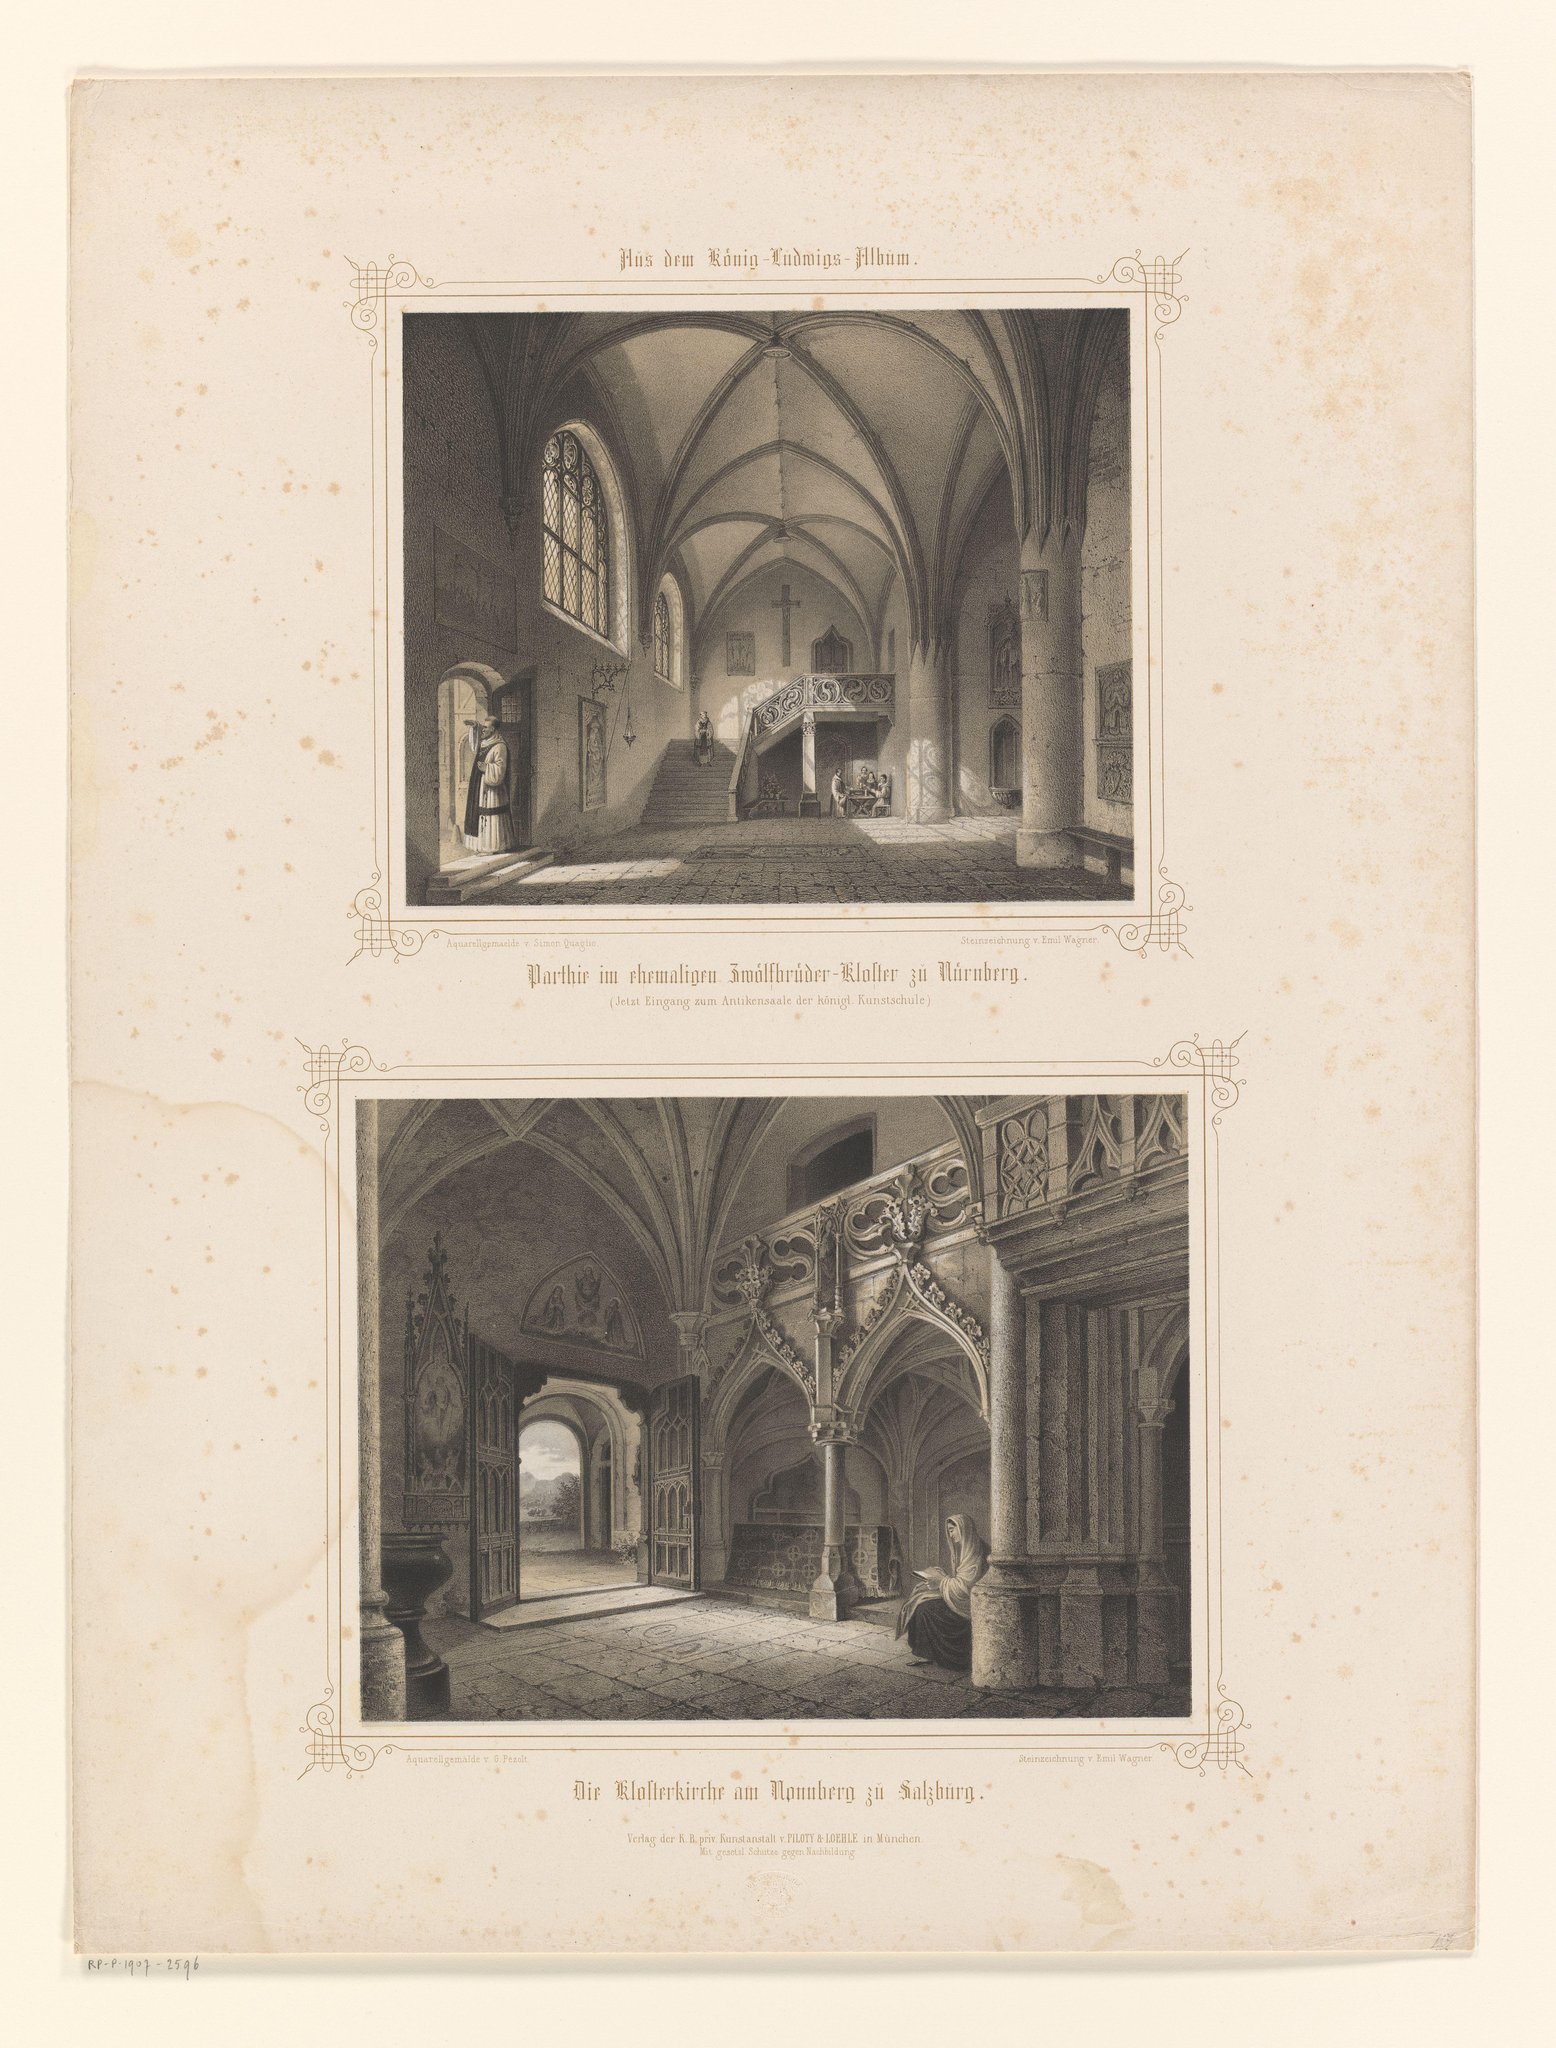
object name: print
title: Album aangeboden aan Lodewijk I van Beieren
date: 1850-1859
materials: paper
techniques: tone lithography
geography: munich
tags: abbey, monastery, convent ~ roman catholic church, interior of church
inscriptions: : ‘Mit gesetzl Schutze gegen Nachbildung’, check stamp: ‘Piloty&Loehle, München’, collector's mark: Lugt 2228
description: Prent afkomstig uit de serie 'Album Seiner Majestät des Königs Ludwig I. von Bayern', verschenen in verschillende afleveringen. De prenten gaan terug op het album dat Lodewijk I van Beieren op 9 oktober 1850 kreeg overhandigd van verschillende kunstenaars.